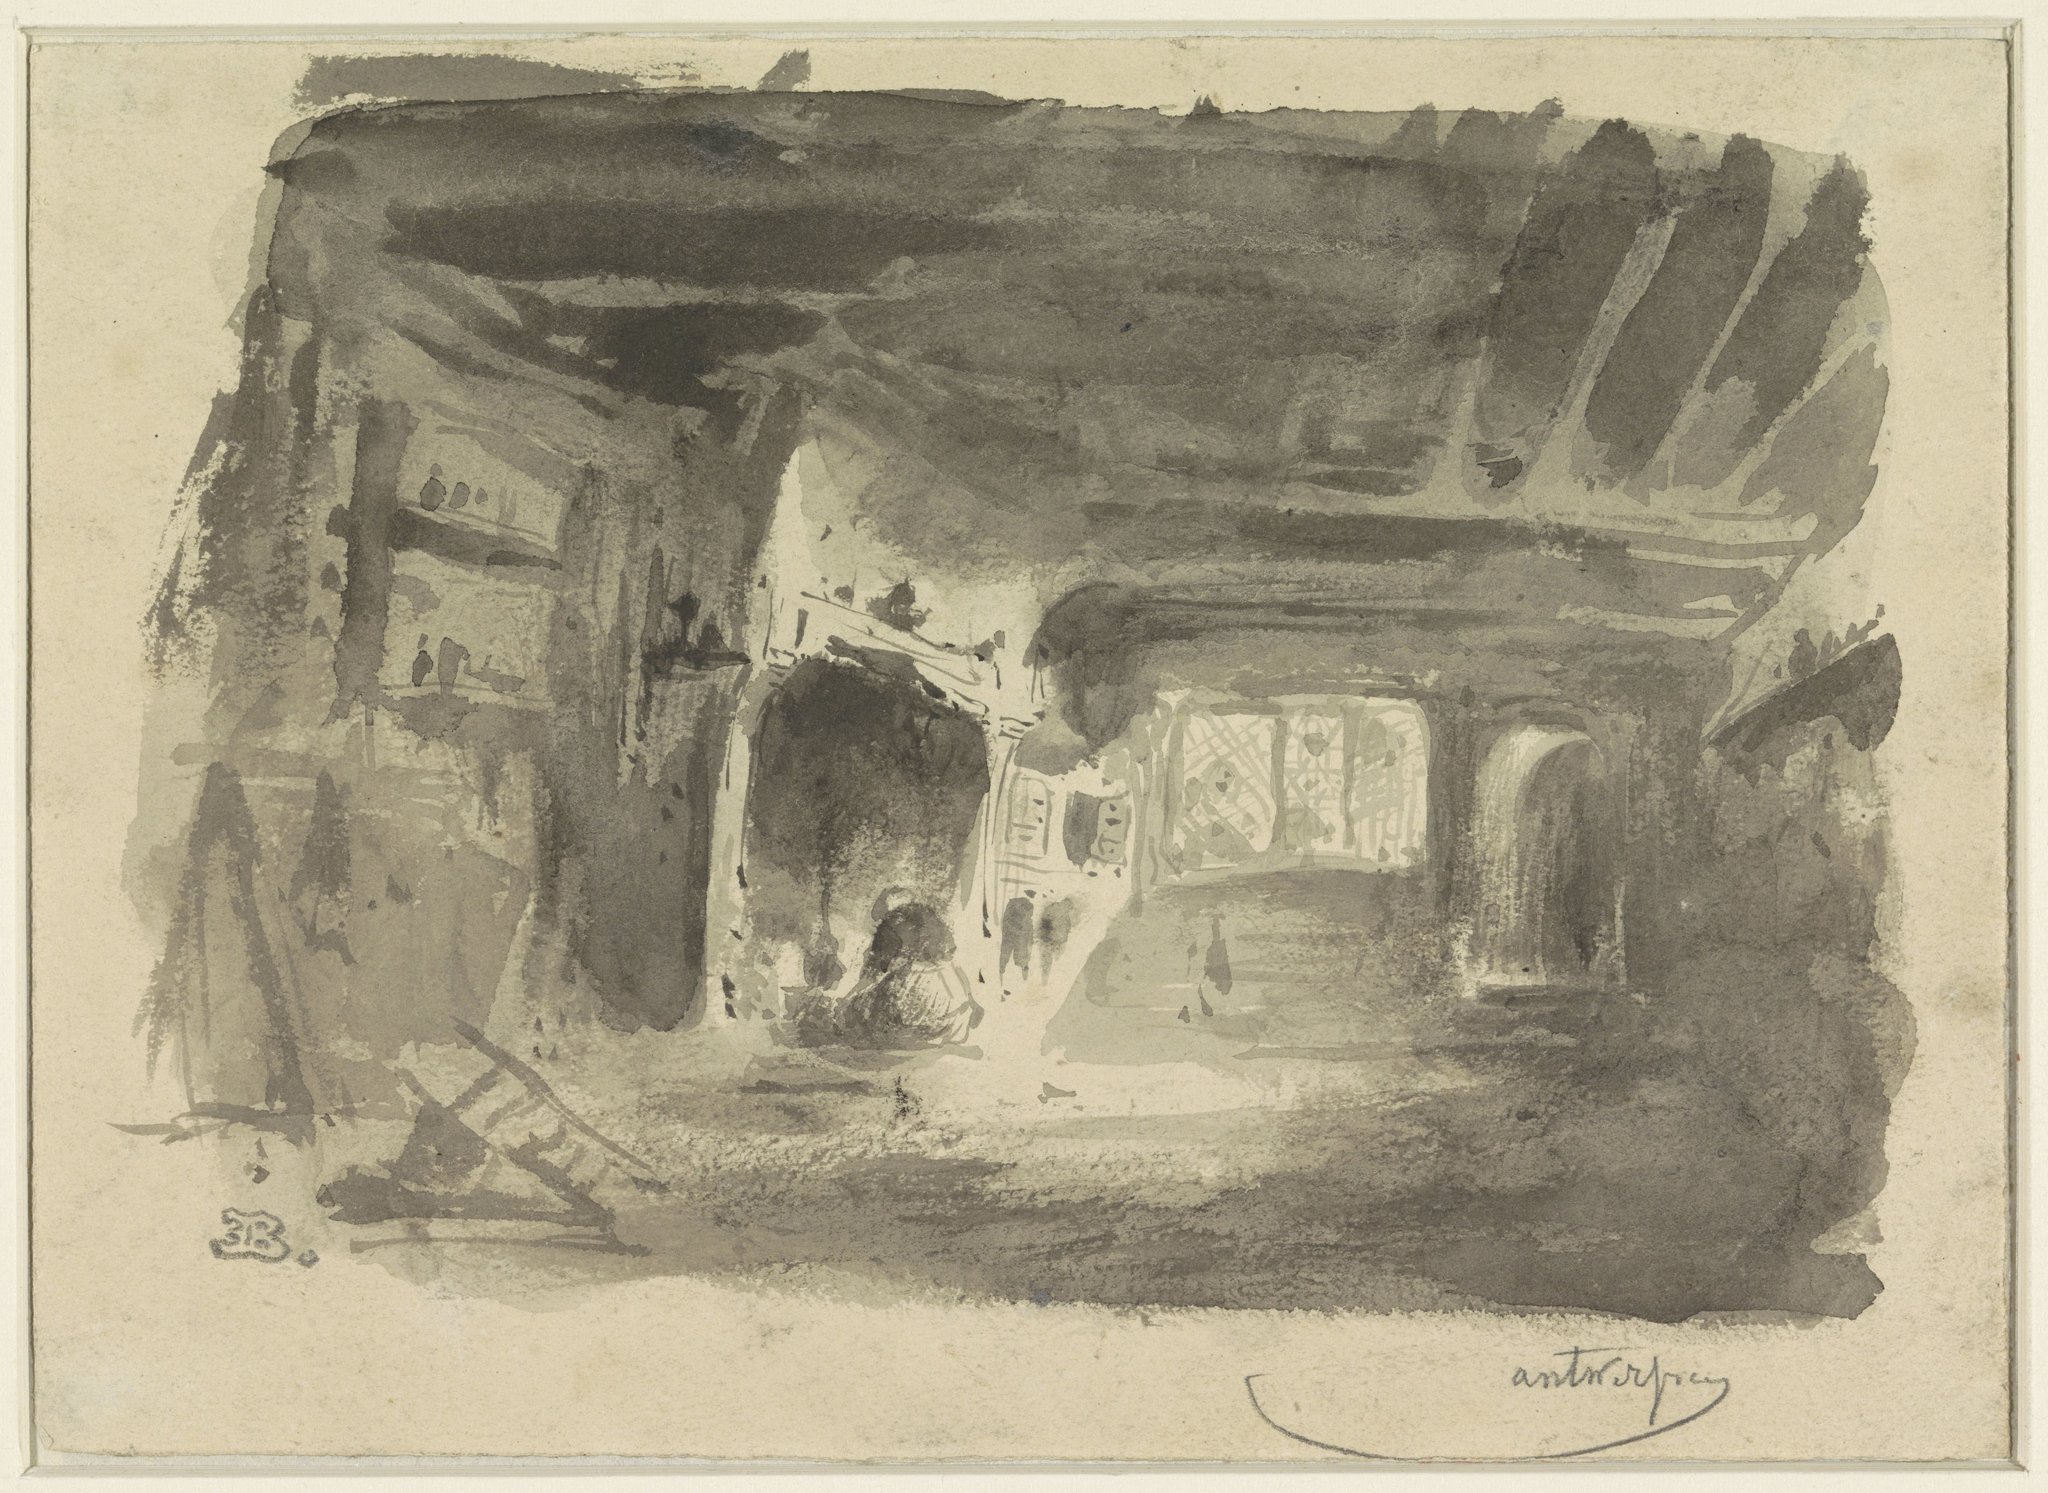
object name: drawing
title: Interieur met geknielde vrouw voor haard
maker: eugène françois de block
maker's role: draughtsman, painter, print maker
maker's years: 1812-1893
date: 1822-1893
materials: paper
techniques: brush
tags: kitchen, other rooms